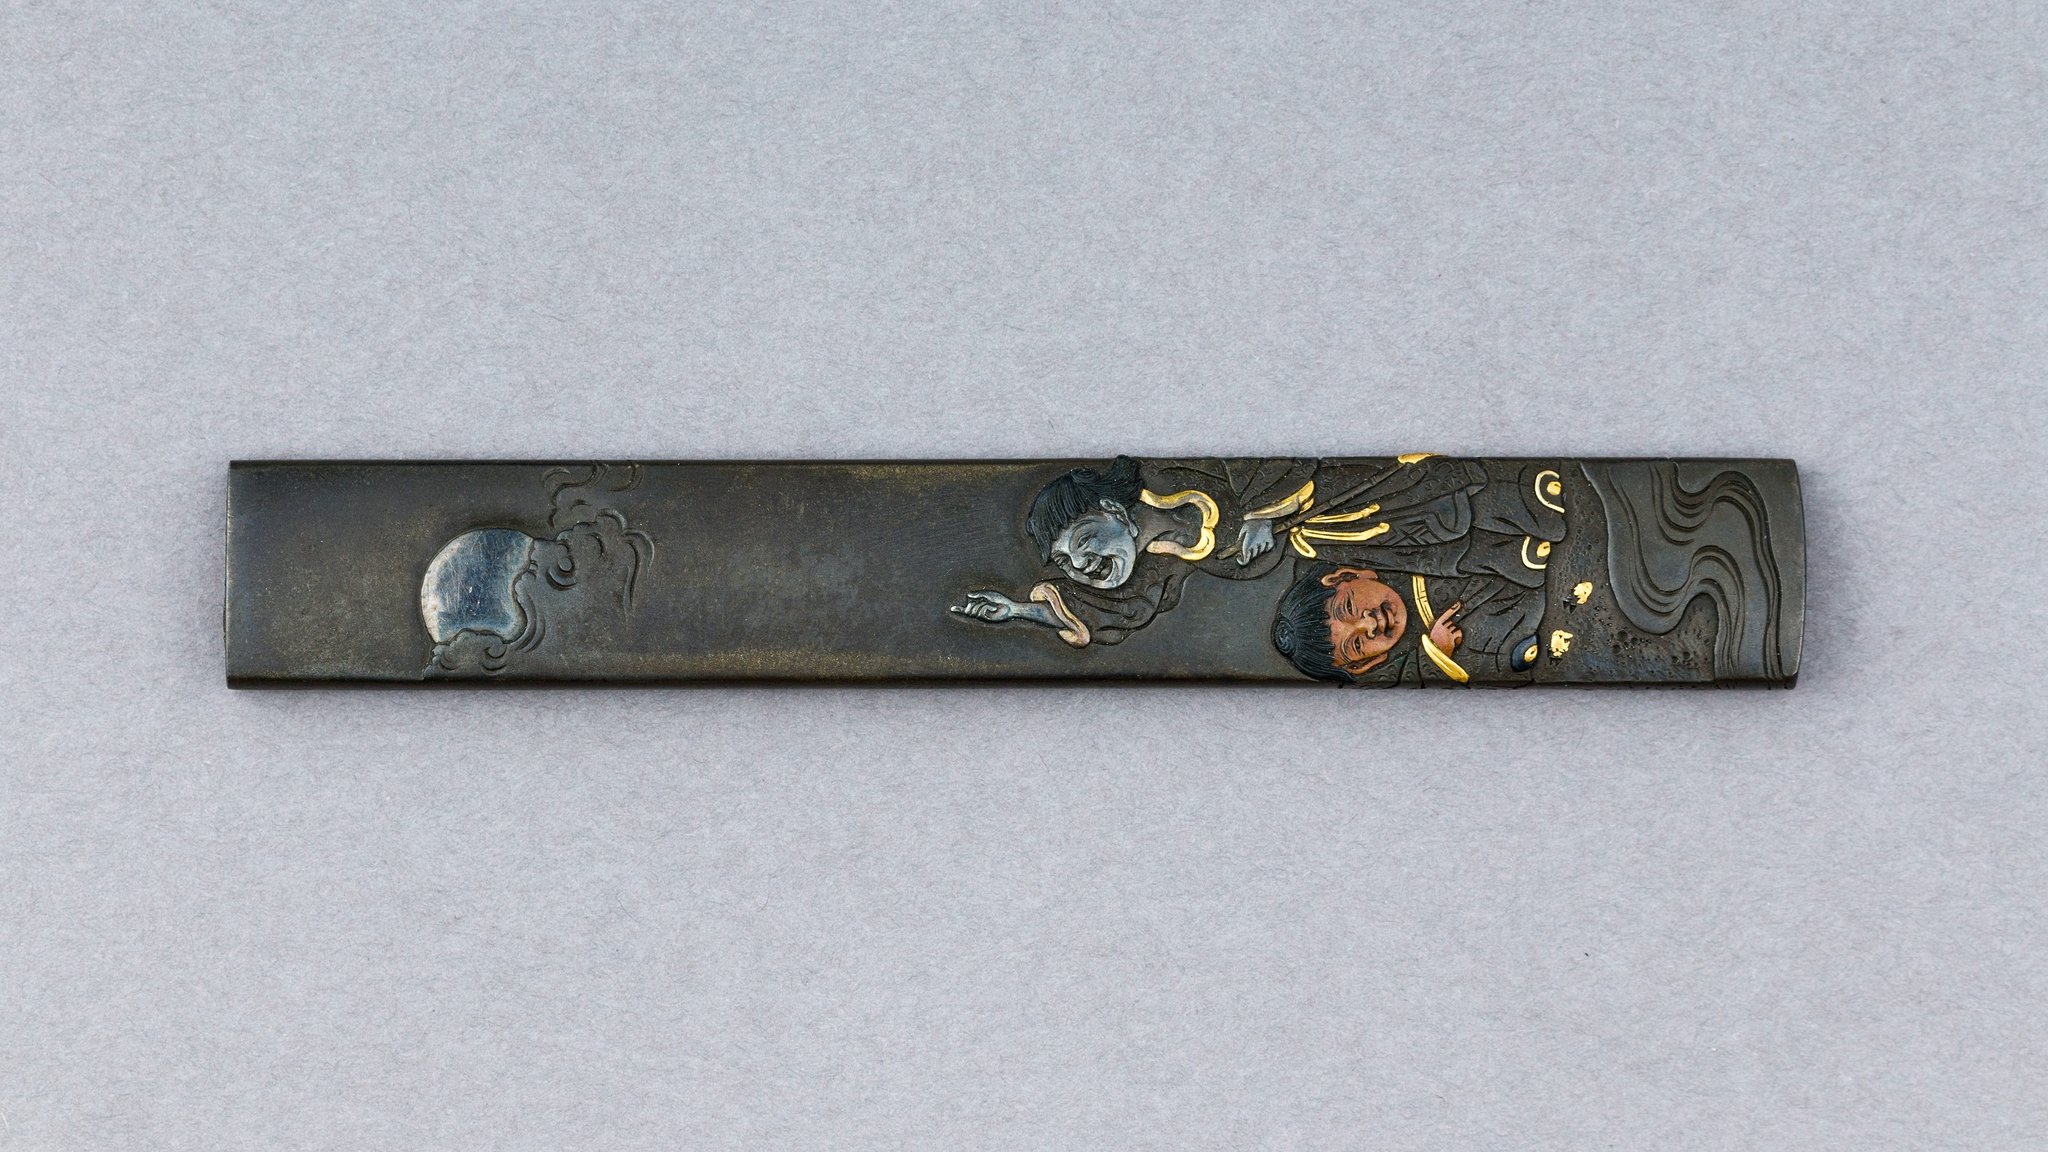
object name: knife handle kozuka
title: Knife Handle (Kozuka)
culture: japanese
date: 1615-1868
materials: copper, gold alloy, silver alloy, gold, silver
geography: japan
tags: human figures